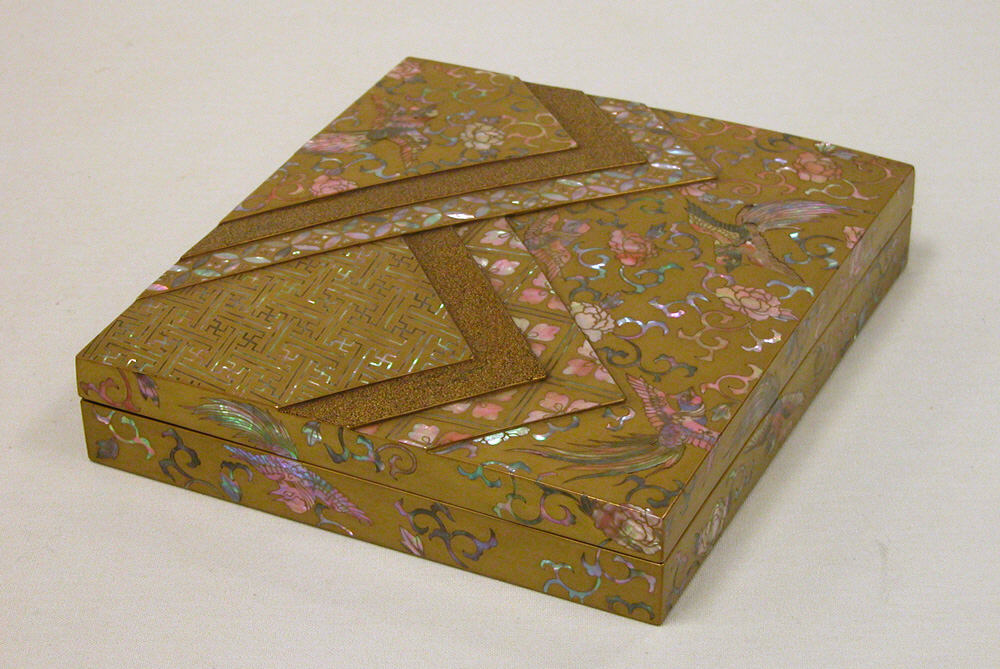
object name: writing box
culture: japanese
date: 1701-1800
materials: gold, lacquer, mother of pearl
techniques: inlay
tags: phoenix